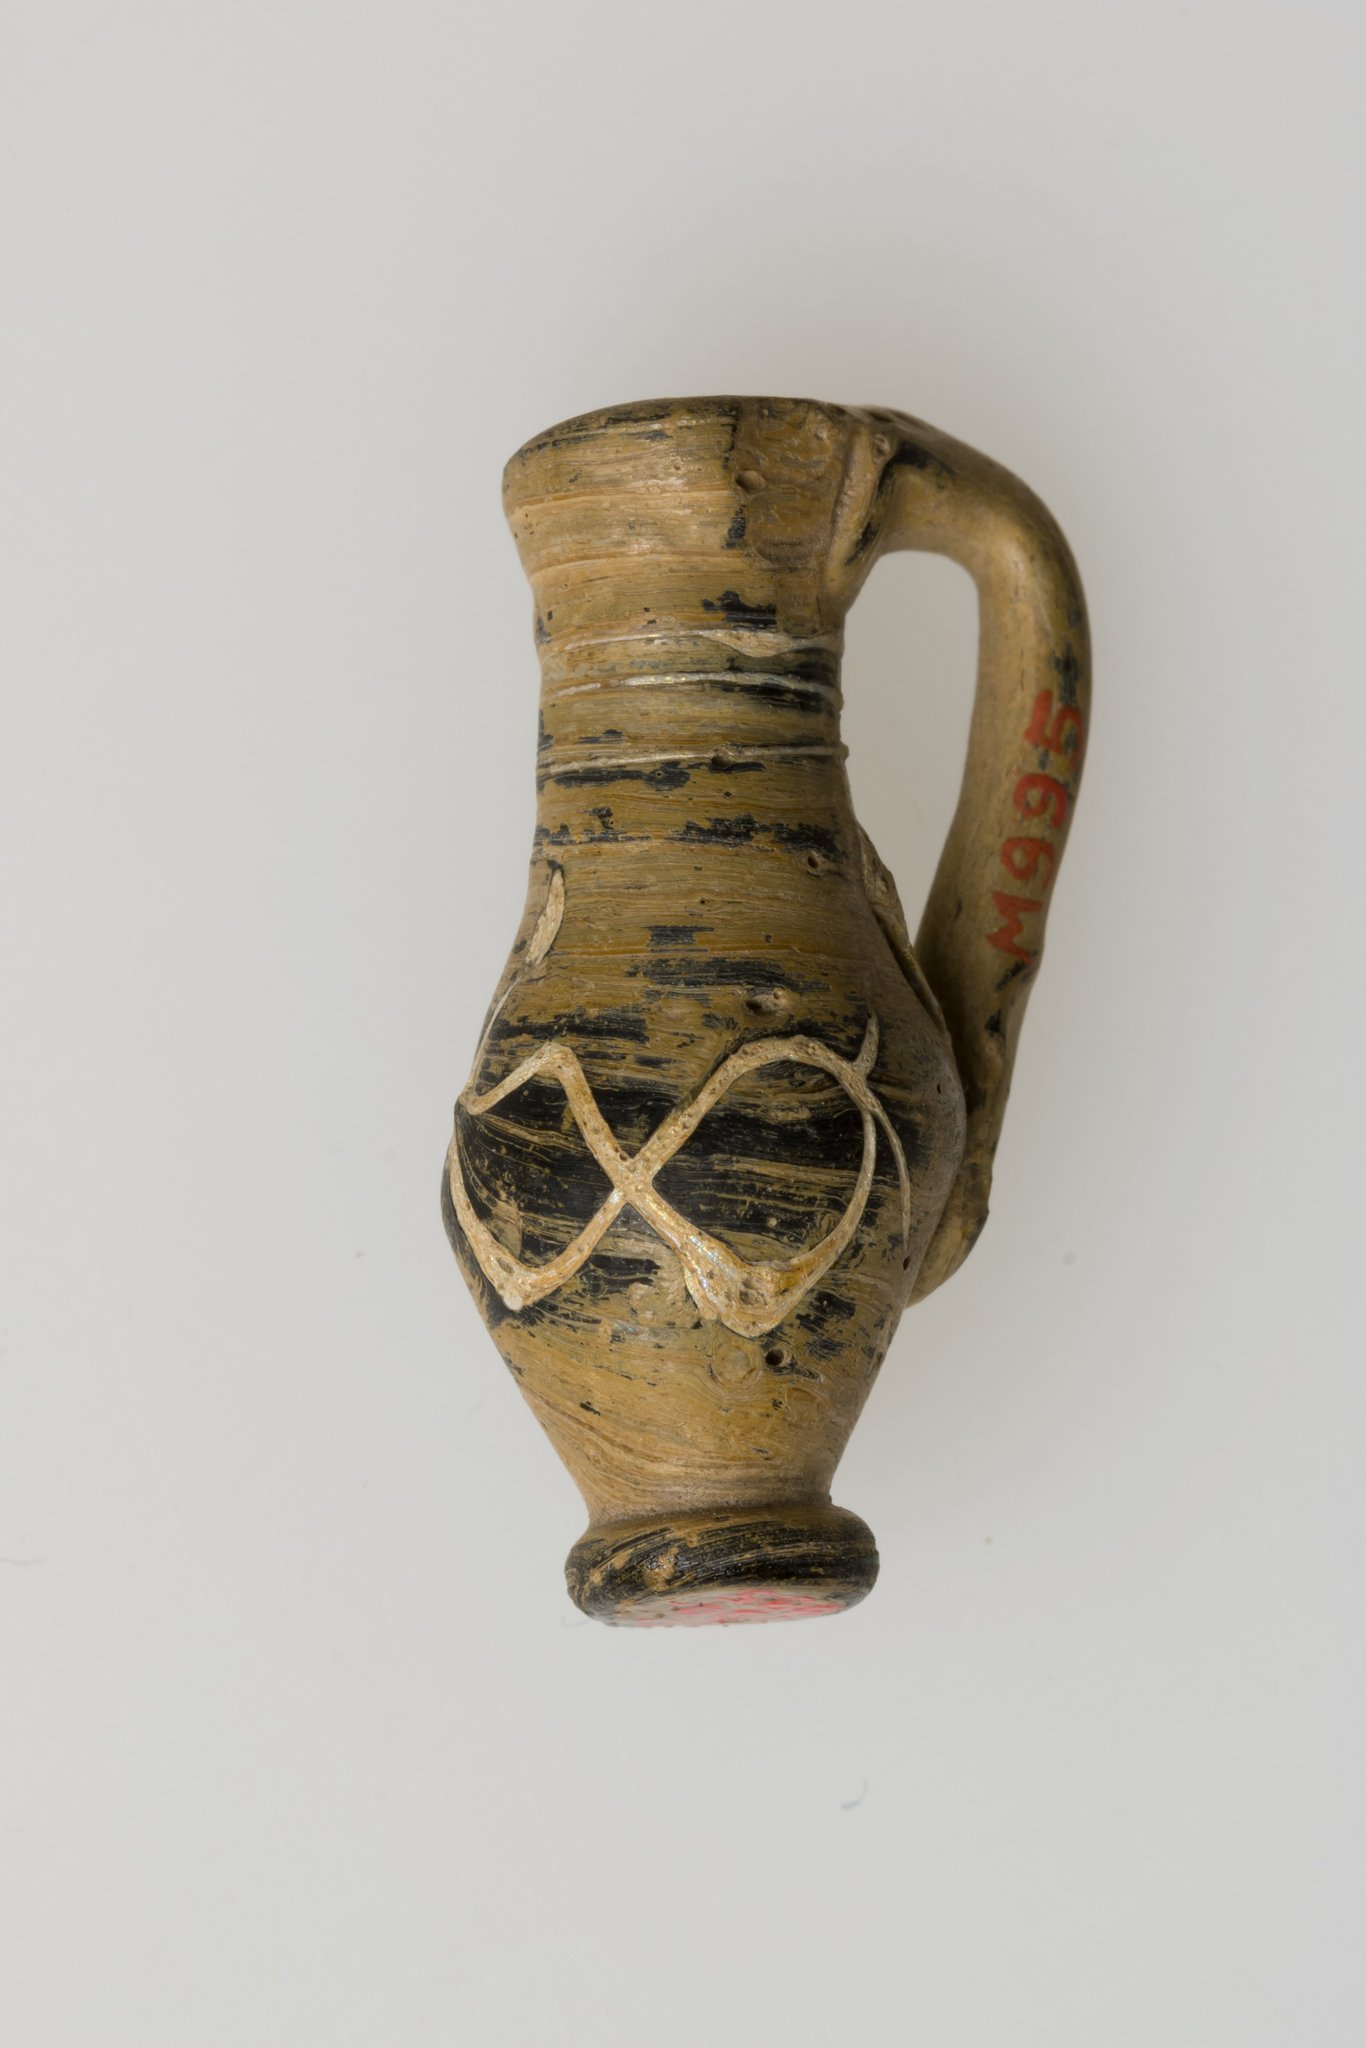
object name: pendant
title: Vase Pendant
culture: egyptian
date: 301-500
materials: glass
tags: vases